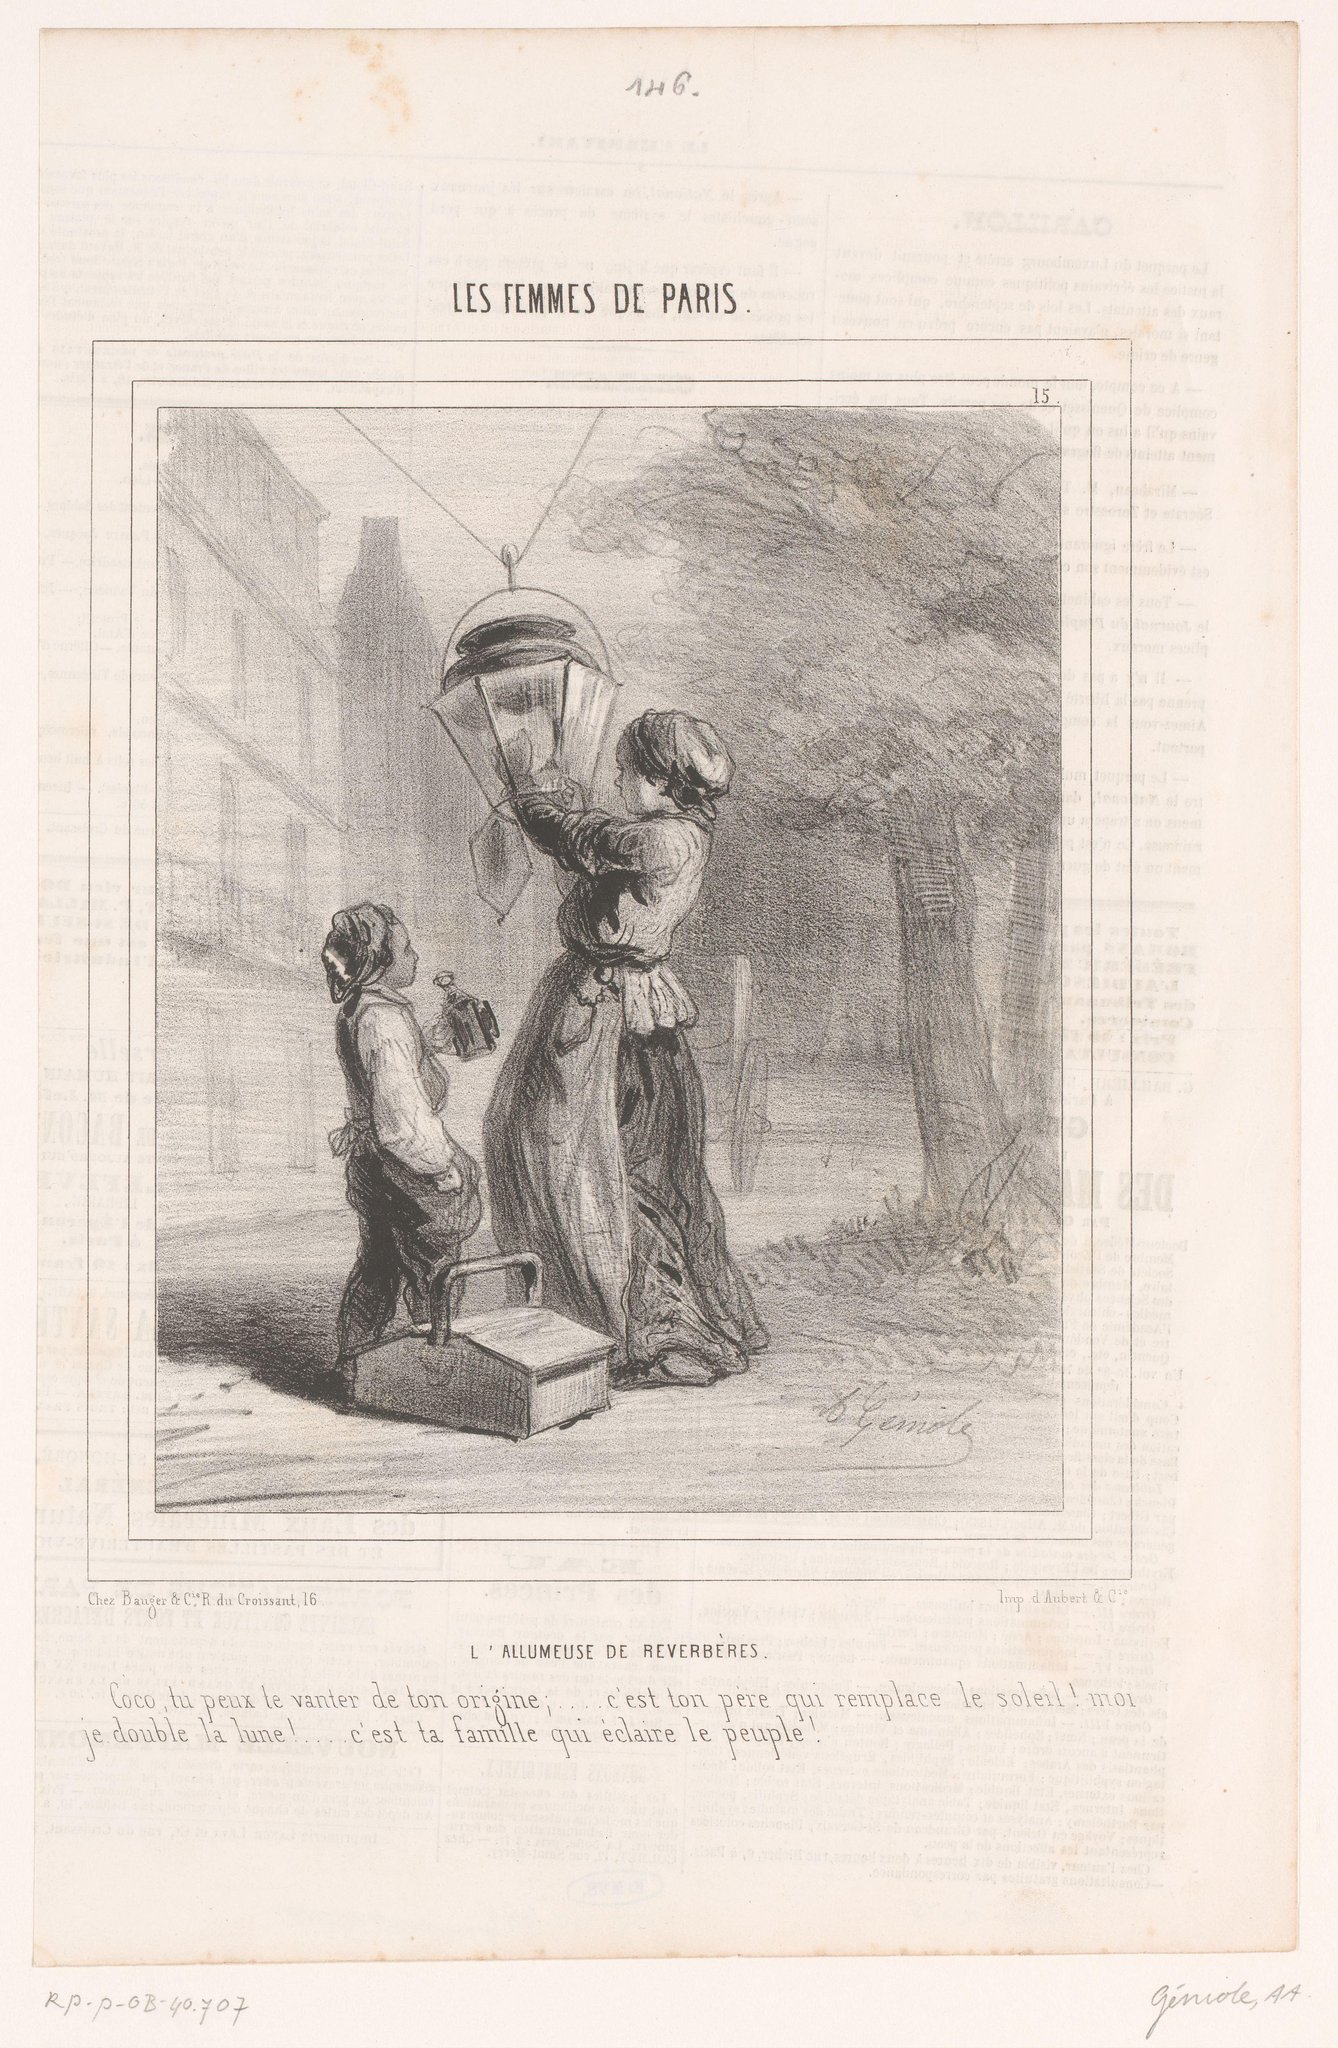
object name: cartoon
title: Vrouw met kind steekt lantaarn aan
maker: alfred andré géniole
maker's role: print maker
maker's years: 1813-1861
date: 1842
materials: paper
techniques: lithograph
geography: paris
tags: mother with son(s) (mother-love), lantern (+ kindling a light; lit, burning light, lamp, candle)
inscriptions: collector's mark: Lugt 2228a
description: Prent gebruikt voor: Le Charivari, 1842.